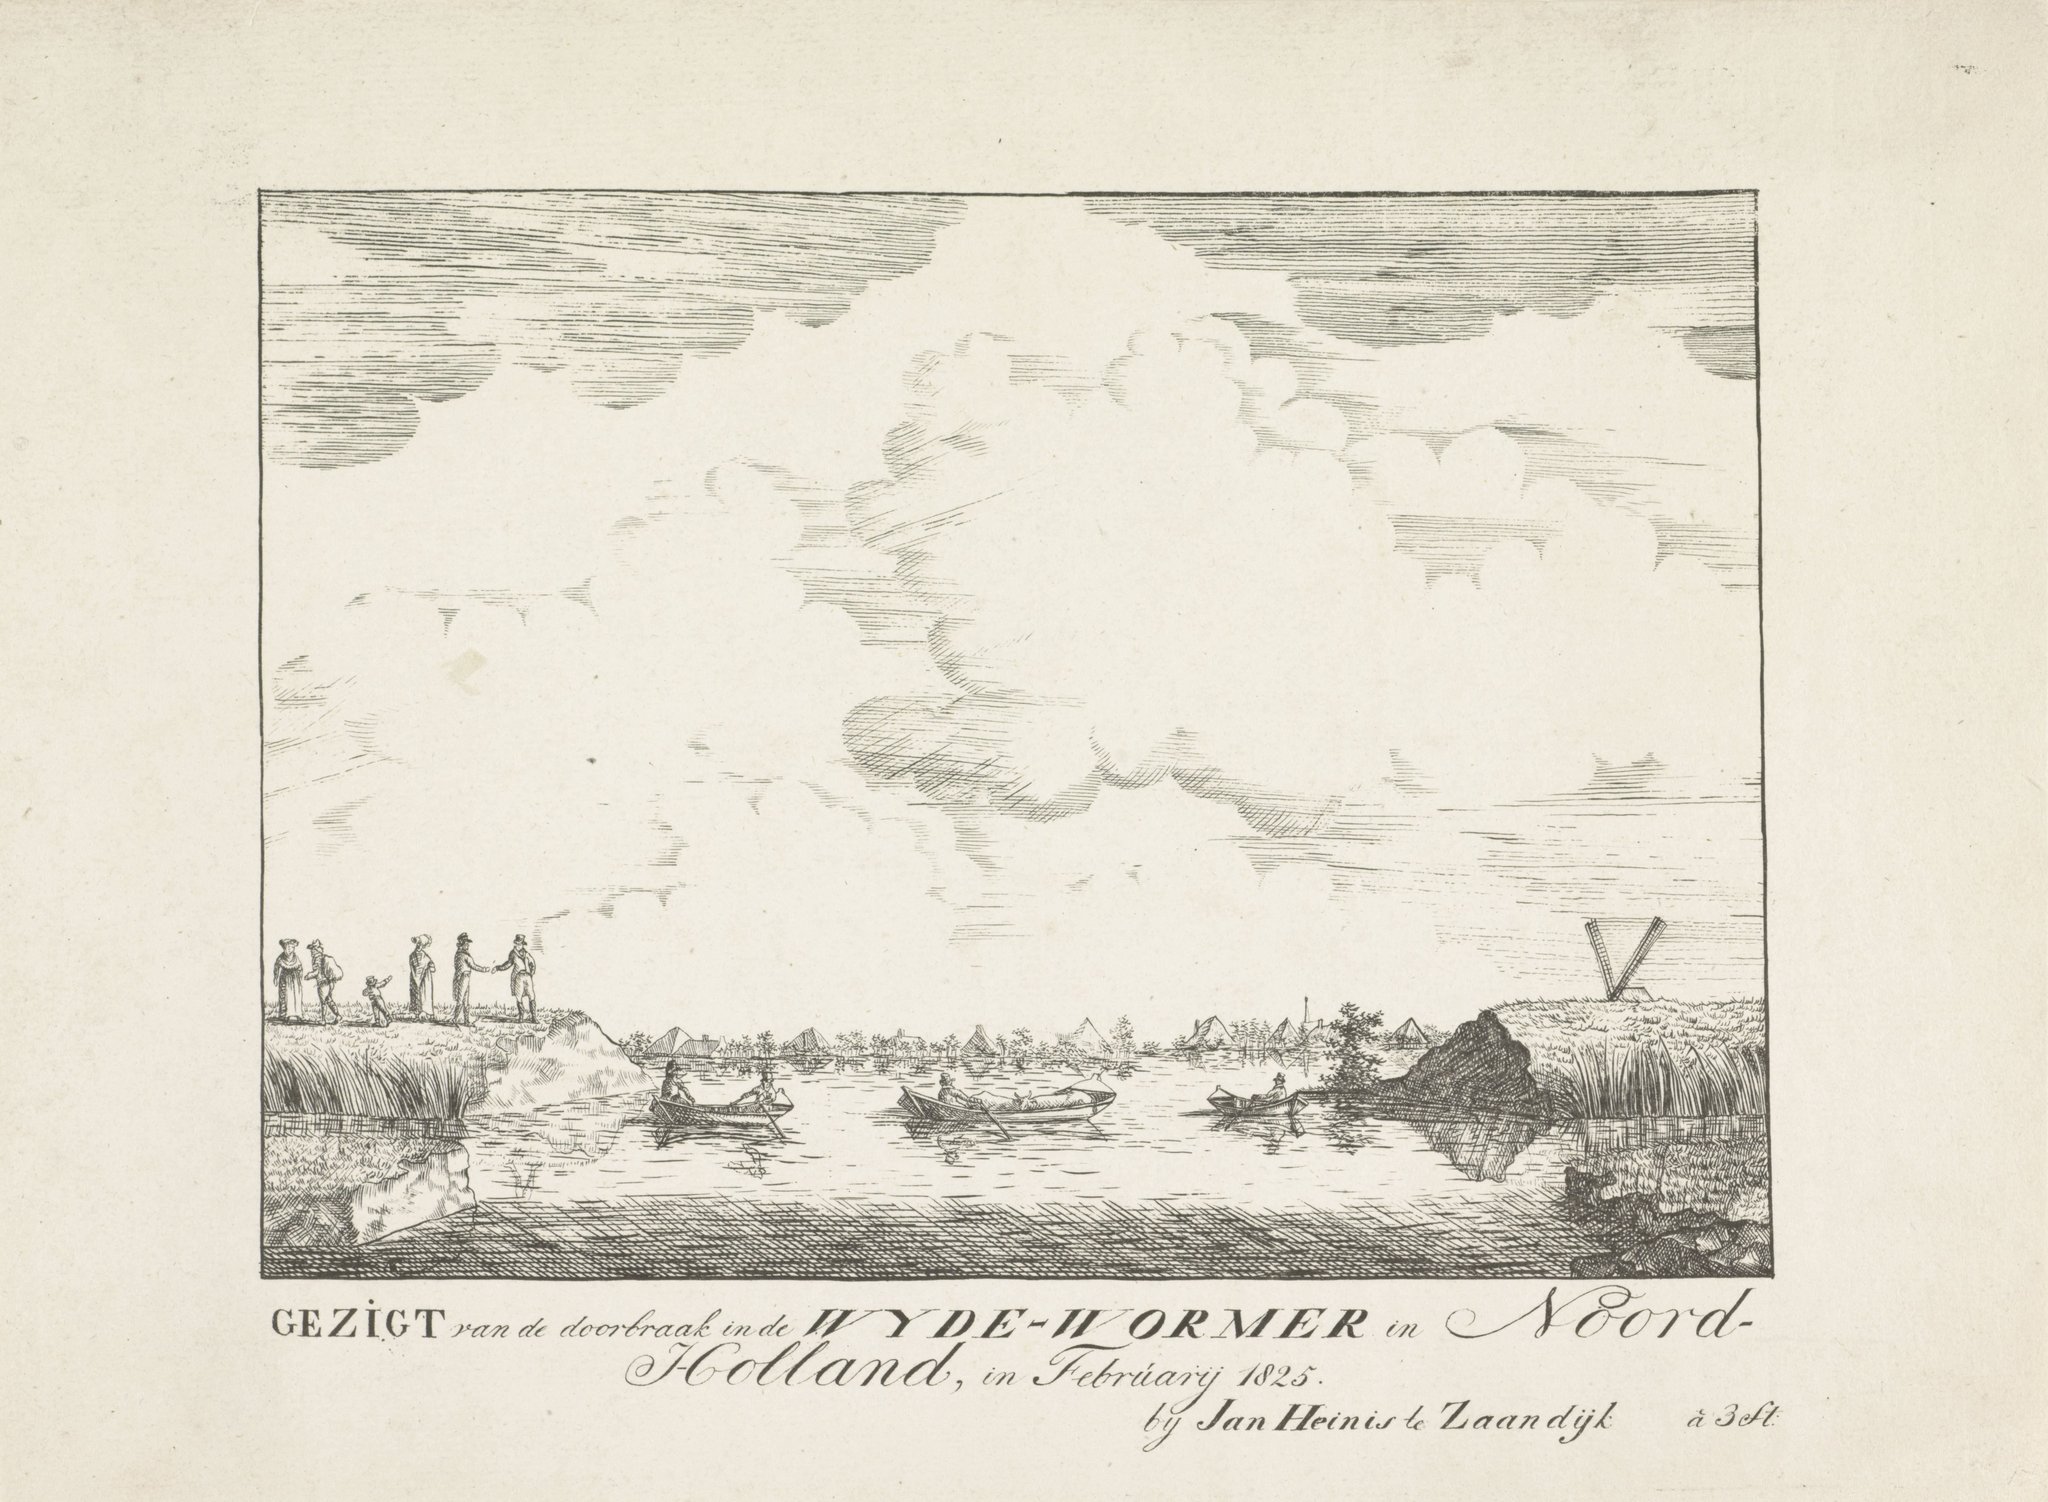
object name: print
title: Gezigt van de doorbraak in de Wyde-Wormer in Noord-Holland, in Februarij 1825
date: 1825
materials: paper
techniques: lithograph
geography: zaandijk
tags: dike-break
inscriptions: collector's mark: Lugt 2228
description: Gezicht op de doorgebroken dijk bij Wijdewormer, tijdens de watersnood begin februari 1825. Op het water enkele bootjes, links mensen op de dijk. Achter de naam van de uitgever is de prijs 'à 3 st.' vermeld.